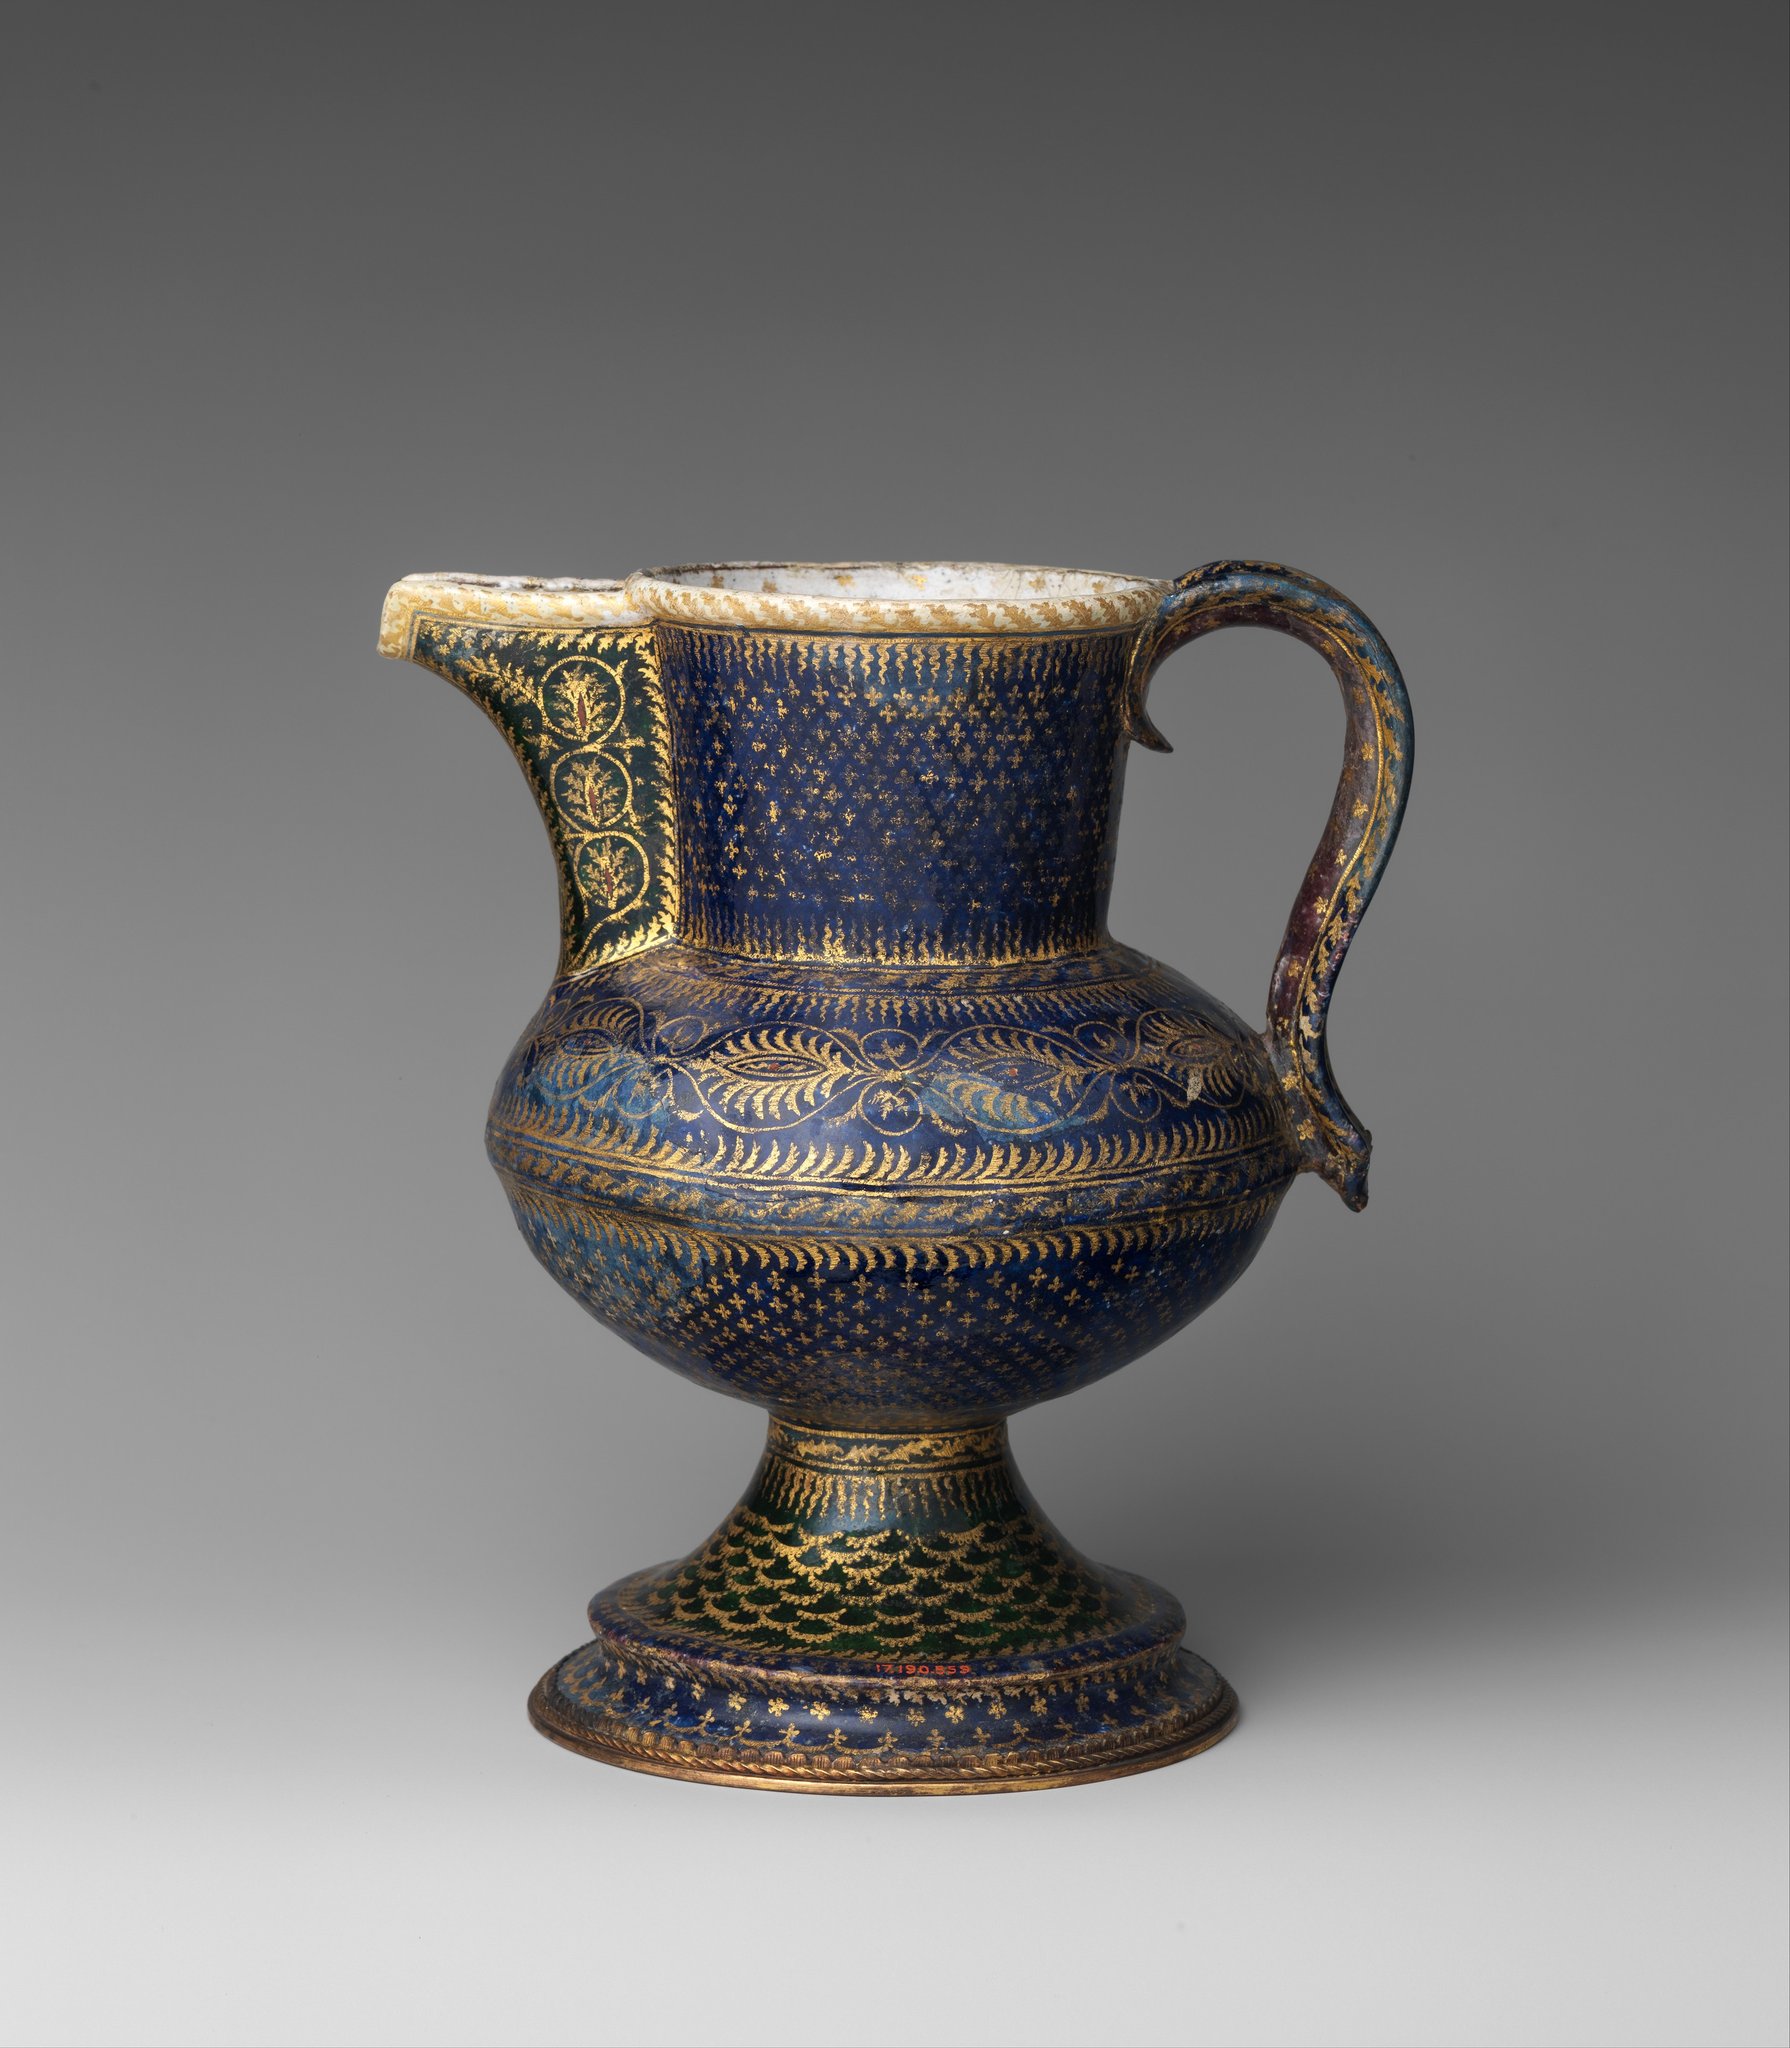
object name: ewer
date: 1467-1533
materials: brass, copper, enamel, gilt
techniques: painting